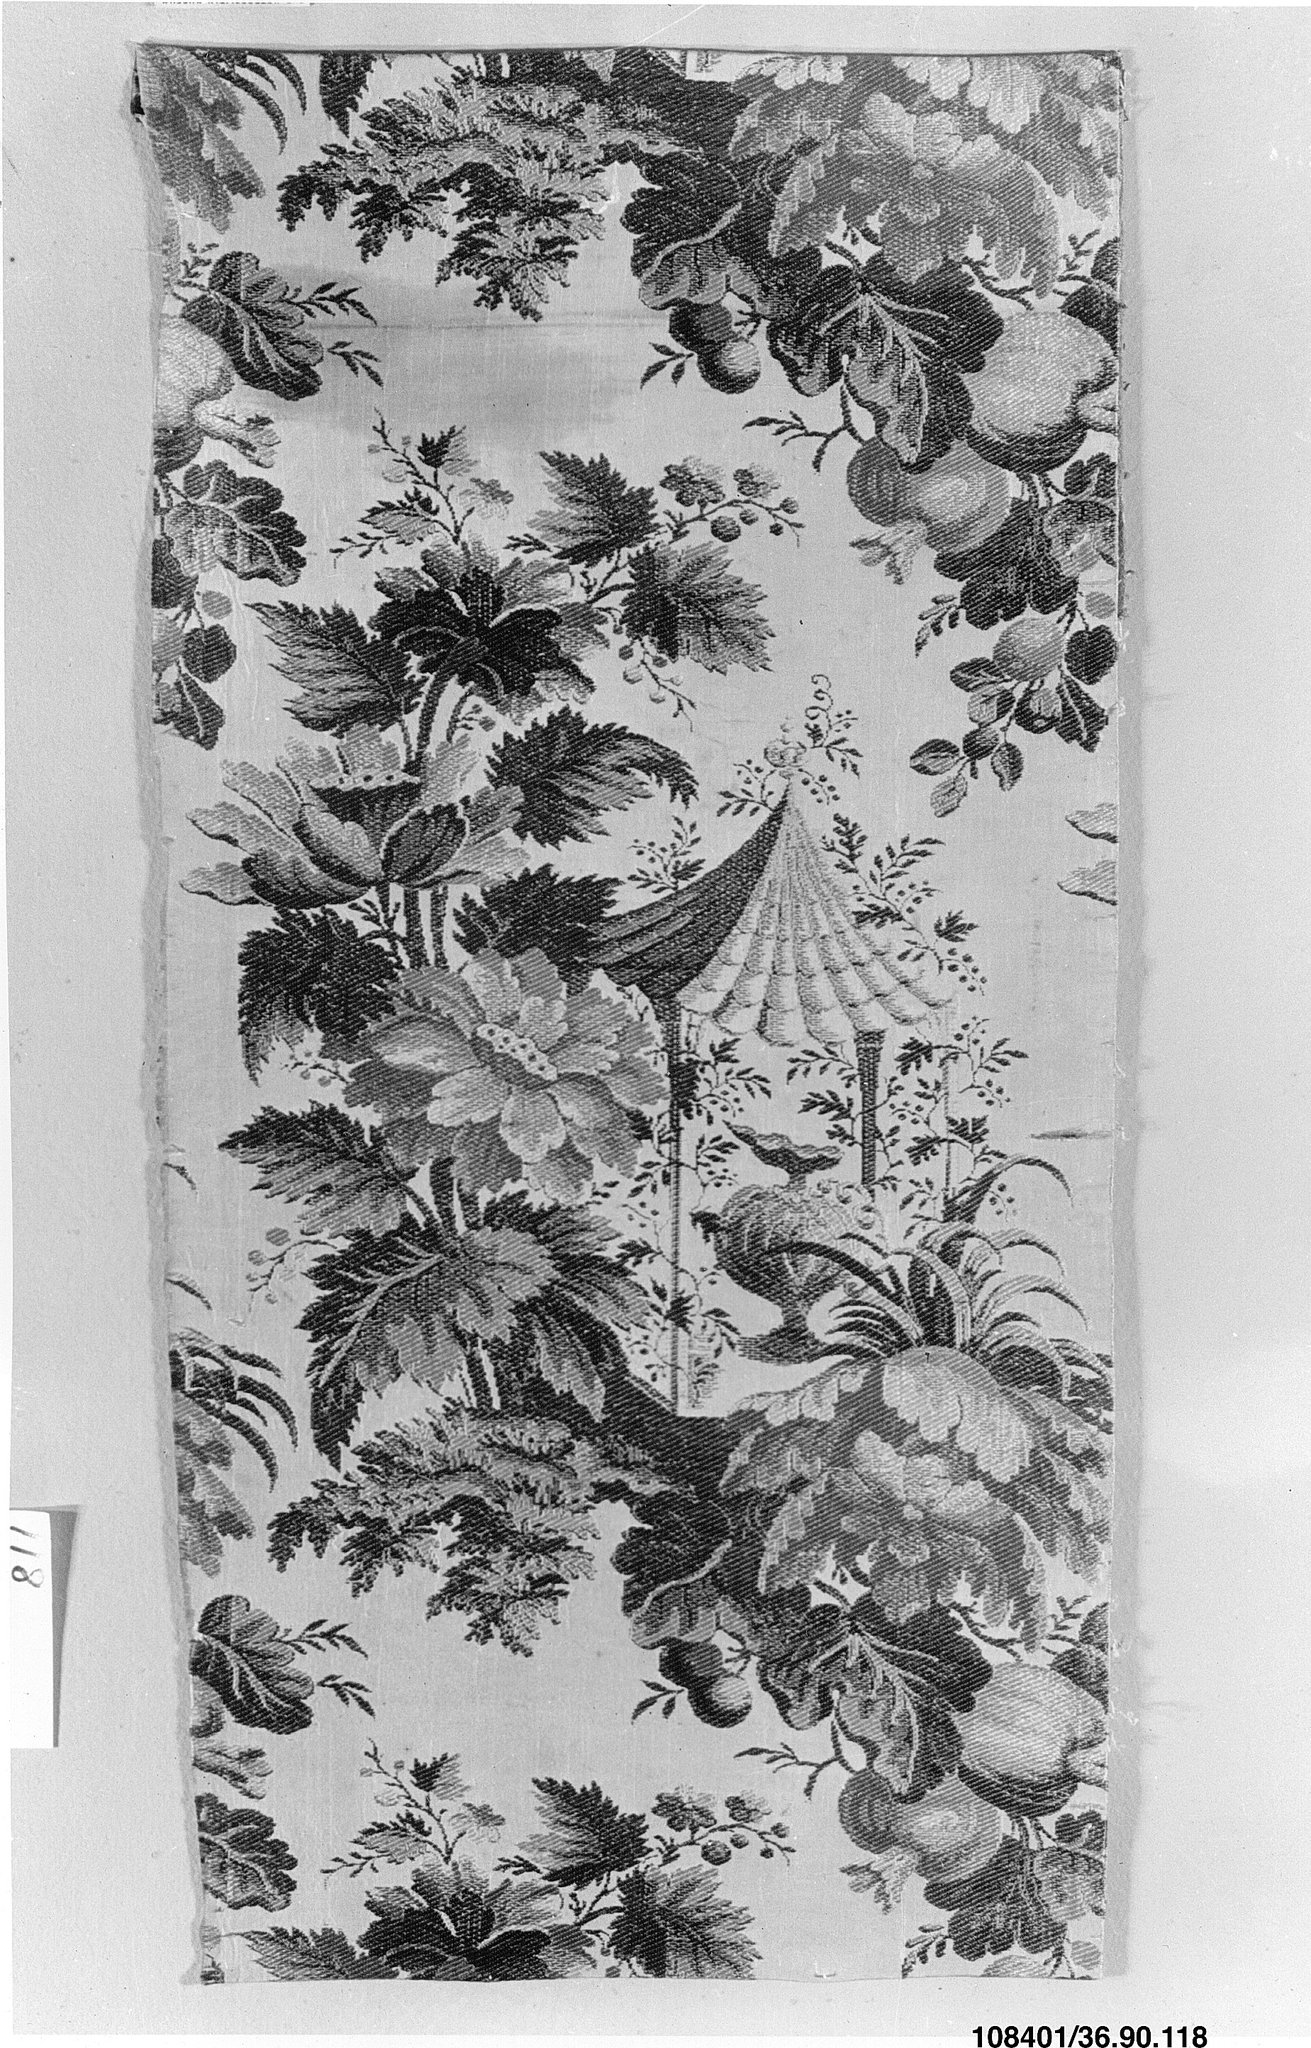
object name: piece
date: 1735-1740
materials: silk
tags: flowers,leaves